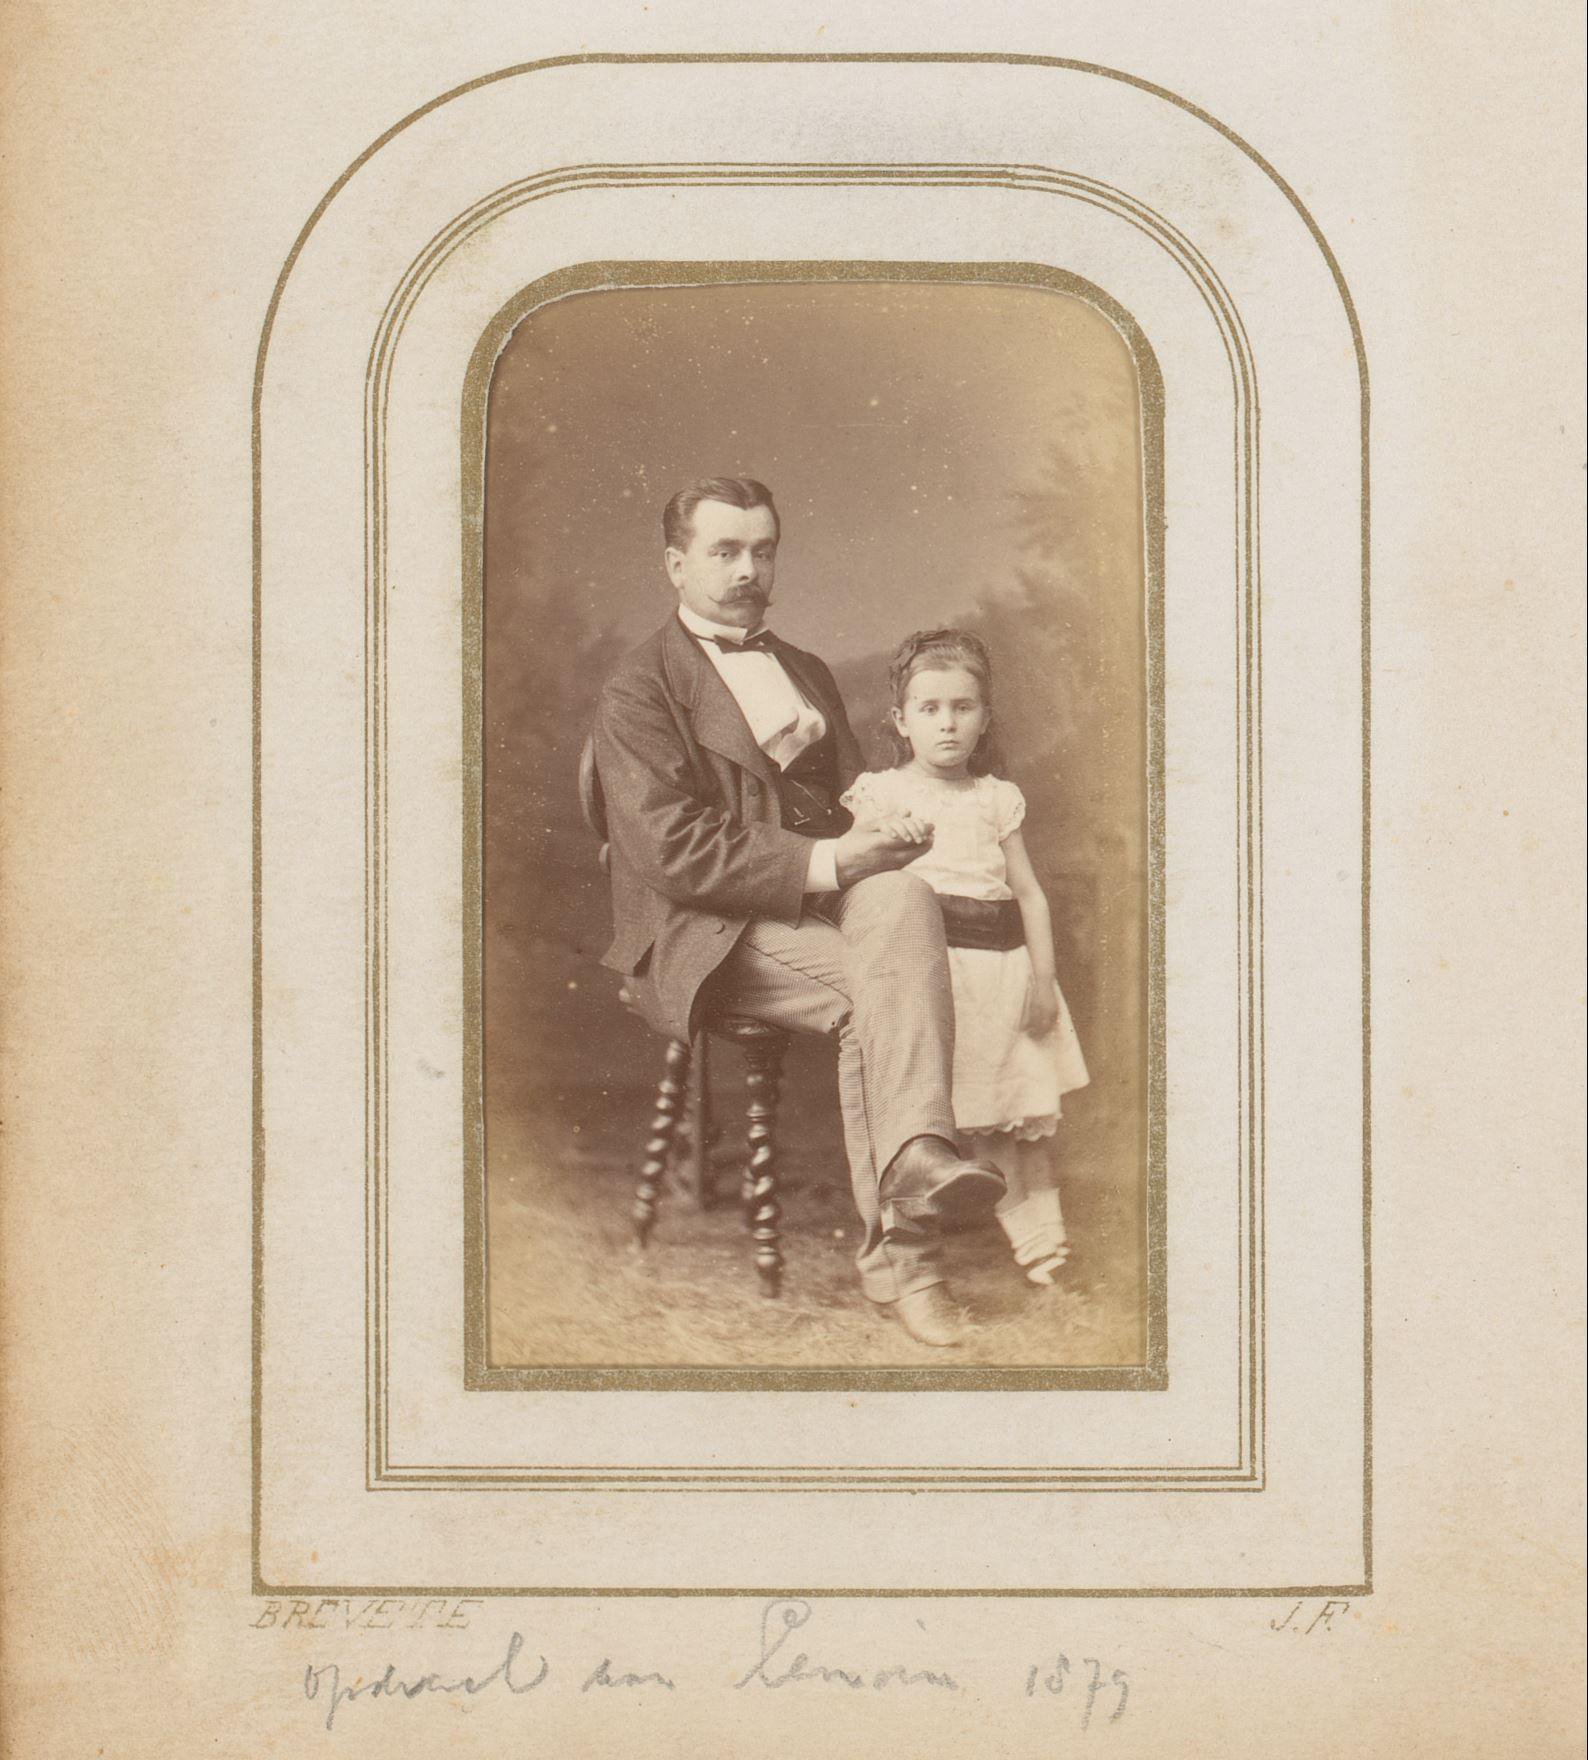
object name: photograph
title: Portret van een vader en dochter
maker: a. pedroni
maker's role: fotograaf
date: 1879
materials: cardboard, photographic support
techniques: albumen print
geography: lille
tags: father and daughter(s) (family group)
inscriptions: inscription: ‘Photographie-Photosculpture/ A. Pedroni/ C de l'Ordre Royal/ 1870/ 42, Rue Lafaurie de Montbadon/ Bordeaux’, annotation: ‘Souvenir offer[...] a/ Majeur Lemoine/ [Dromis]/ [9 X 79]’